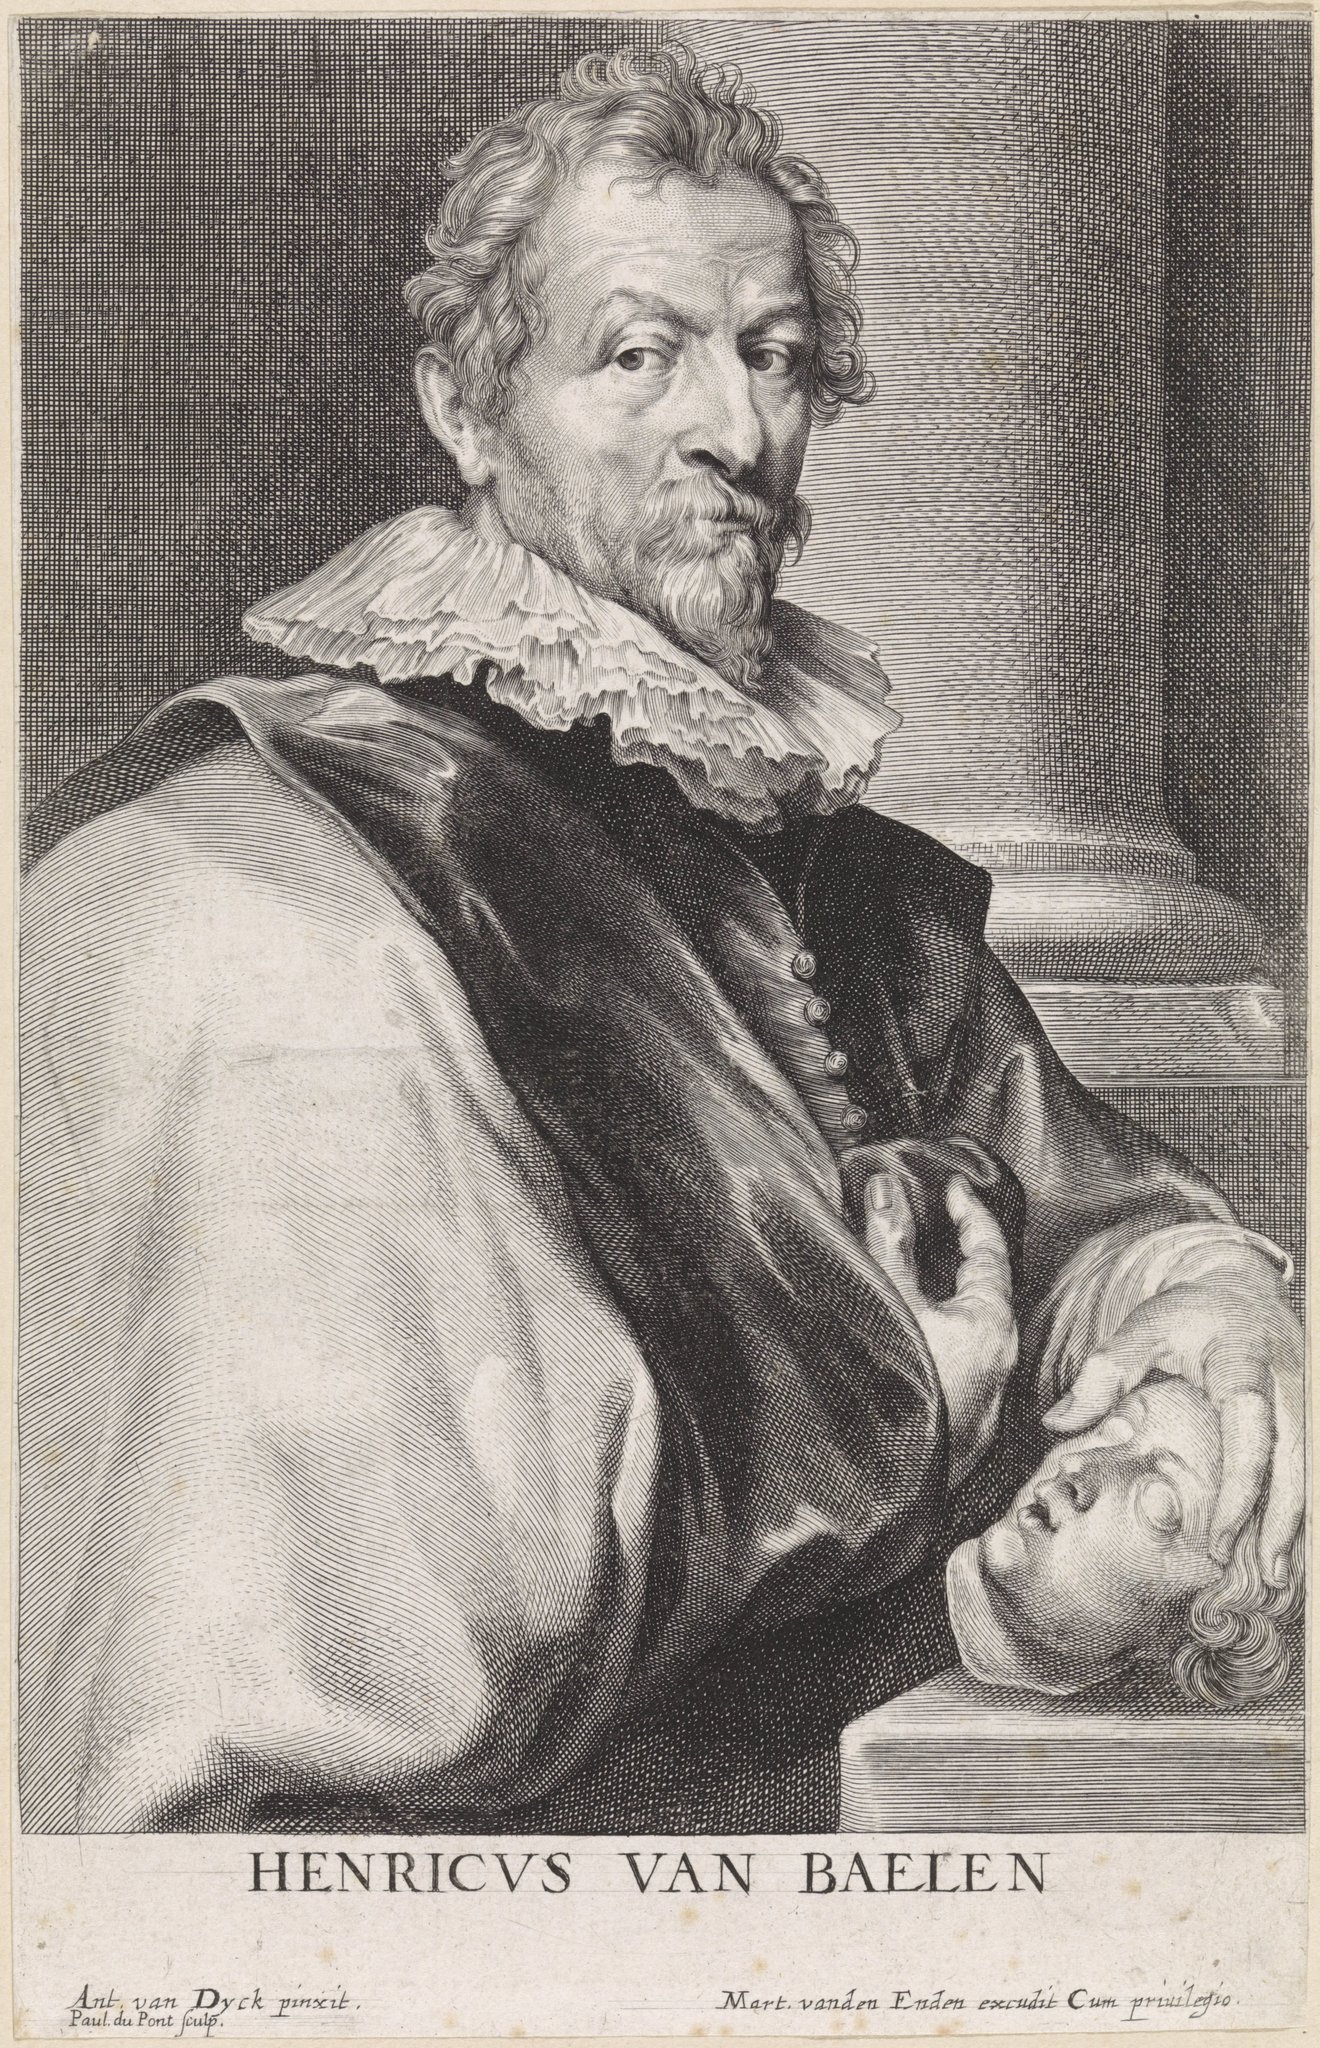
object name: print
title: Portret van de schilder Hendrik van Balen (I)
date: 1616-1657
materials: paper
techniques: engraving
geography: antwerp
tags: antwerp, painter, draughtsman, hendrik van balen (i), portrait, self-portrait of painter, piece of sculpture, reproduction of a piece of sculpture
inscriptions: collector's mark: Lugt 240